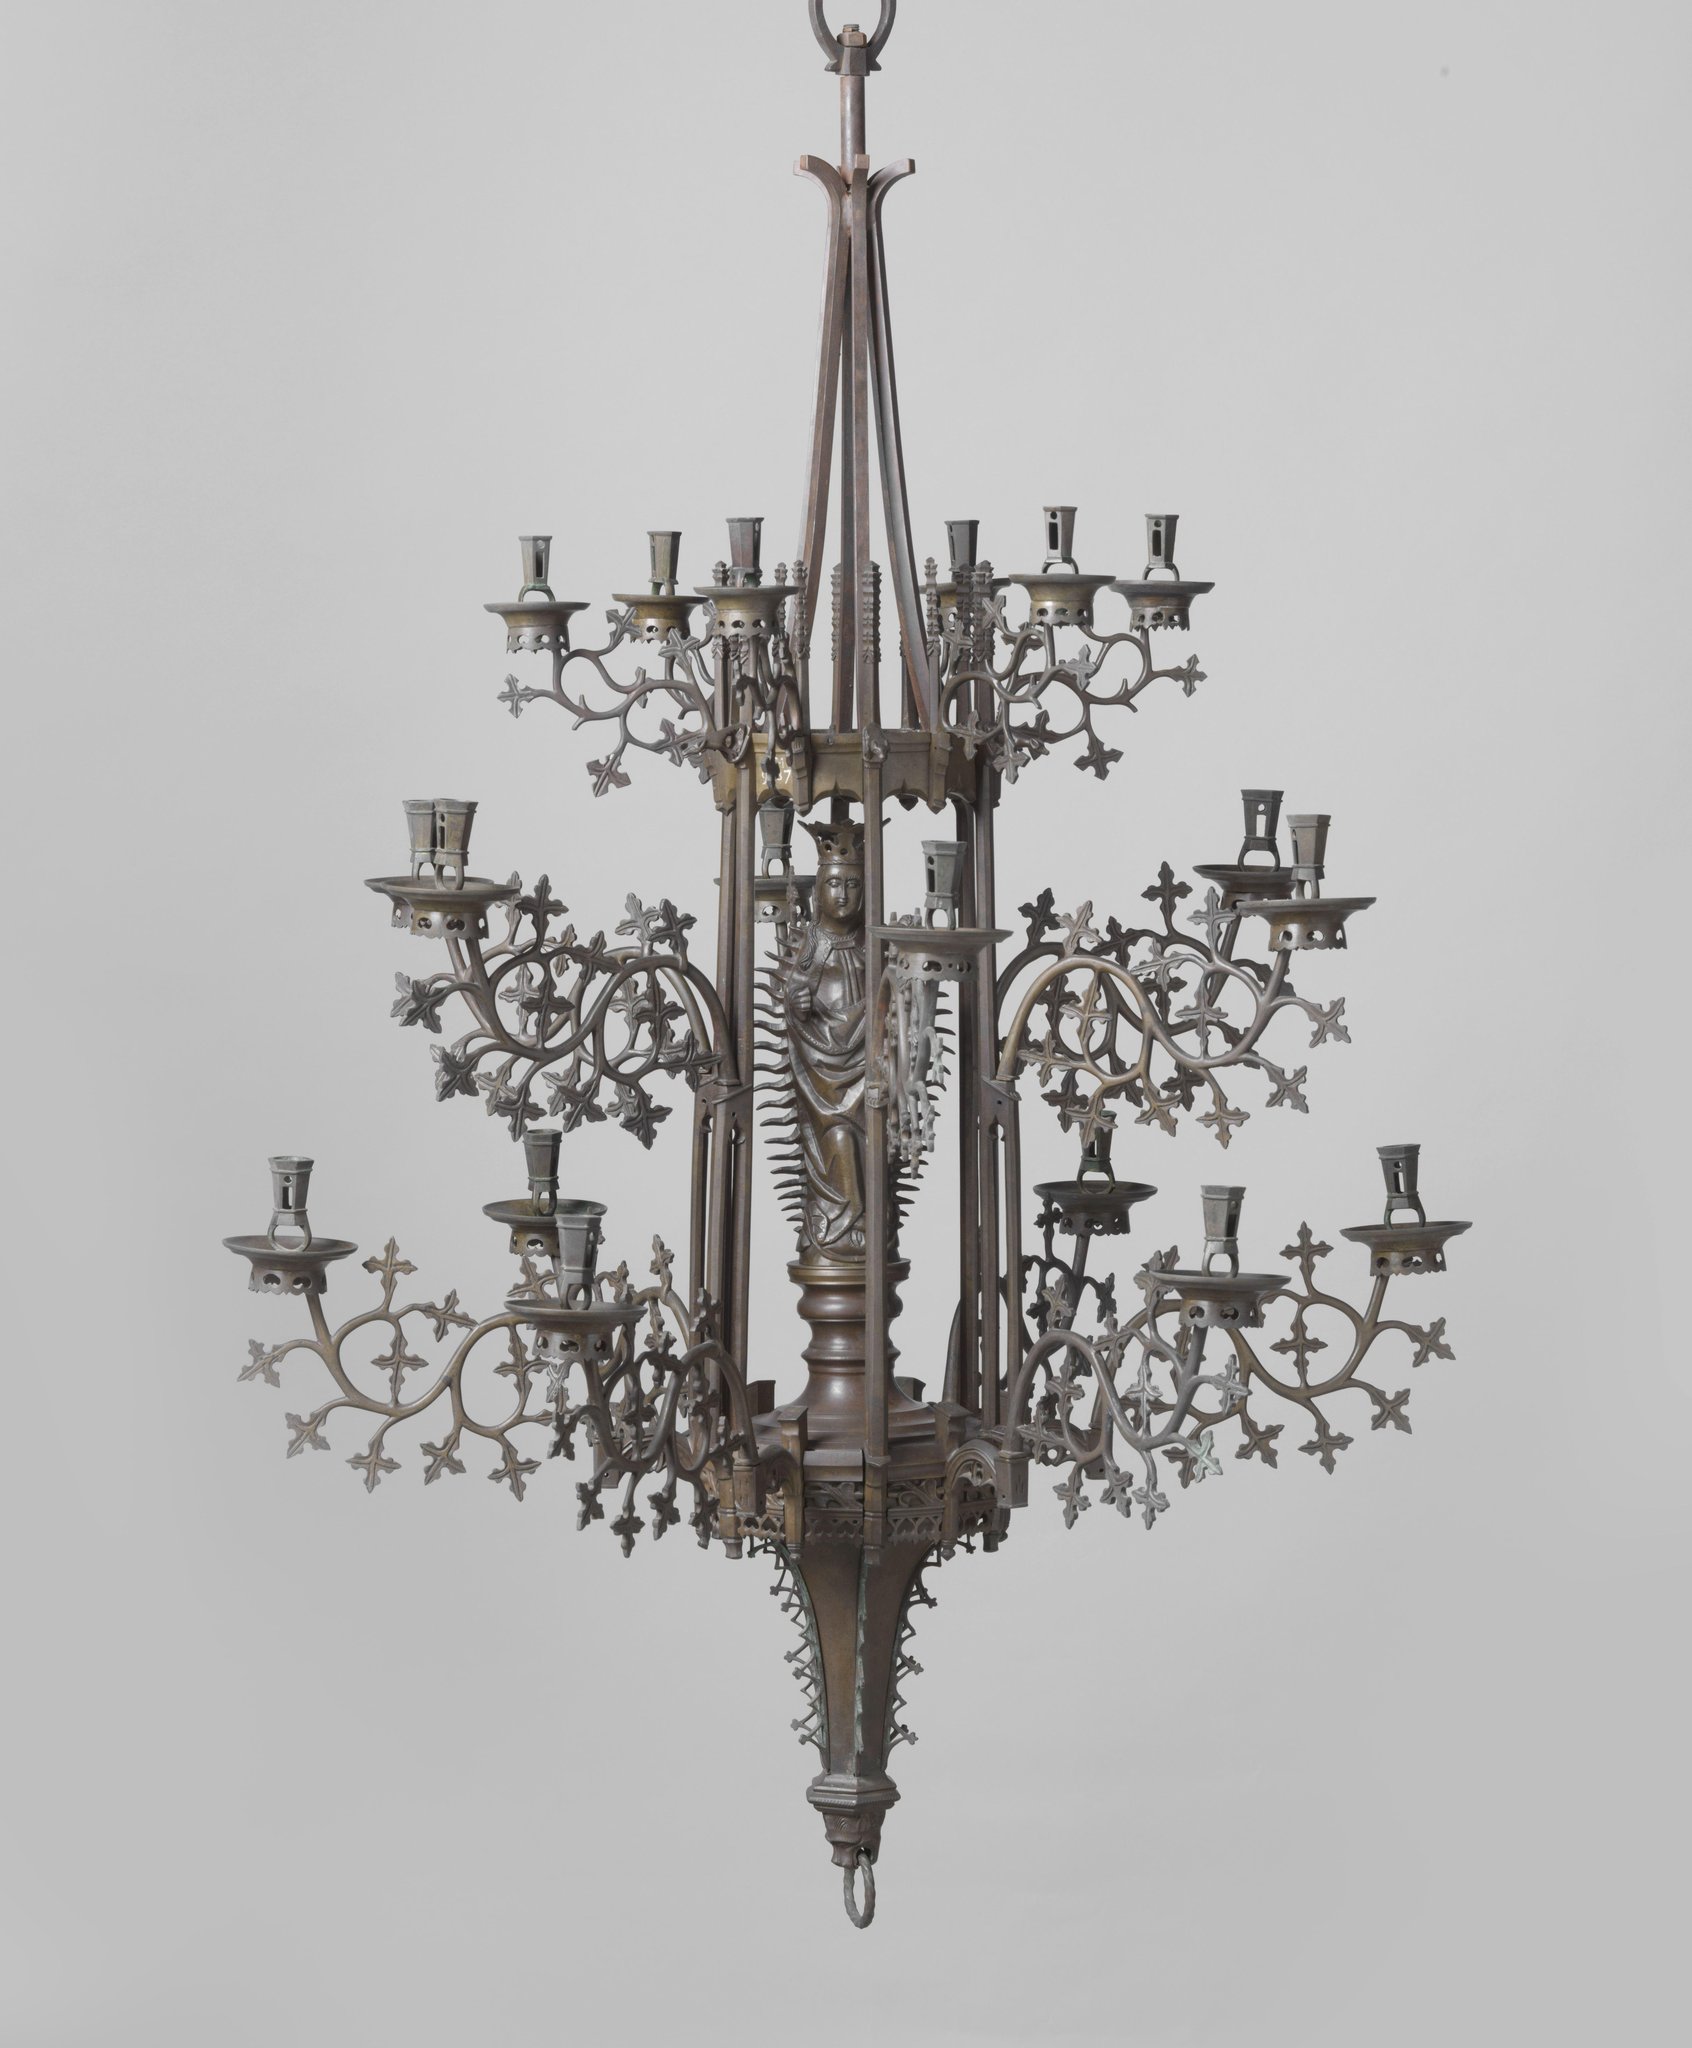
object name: chandelier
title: Kaarsenarm van kaarsenkroon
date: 1475-1485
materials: brass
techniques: casting, metalworking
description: Kaarsenarm behorende bij een kaarsenkroon van drie hoogten met Mariakapel in het midden. De arm is twee maal gebogen en heeft vijf bladeren. Aan het uiteinde rust de vetvanger, die aan de onderzijde een verticale gekartelde rand met kruisbloemmotieven heeft. De kaarsenhouder is zesvlakkig met een geperforeerde zijde aan voor- en achterkant en heeft een verticaal ringvormig onderstuk. Dit is de zesde arm van de bovenste ring (de kap), genummerd met 6 stippen.